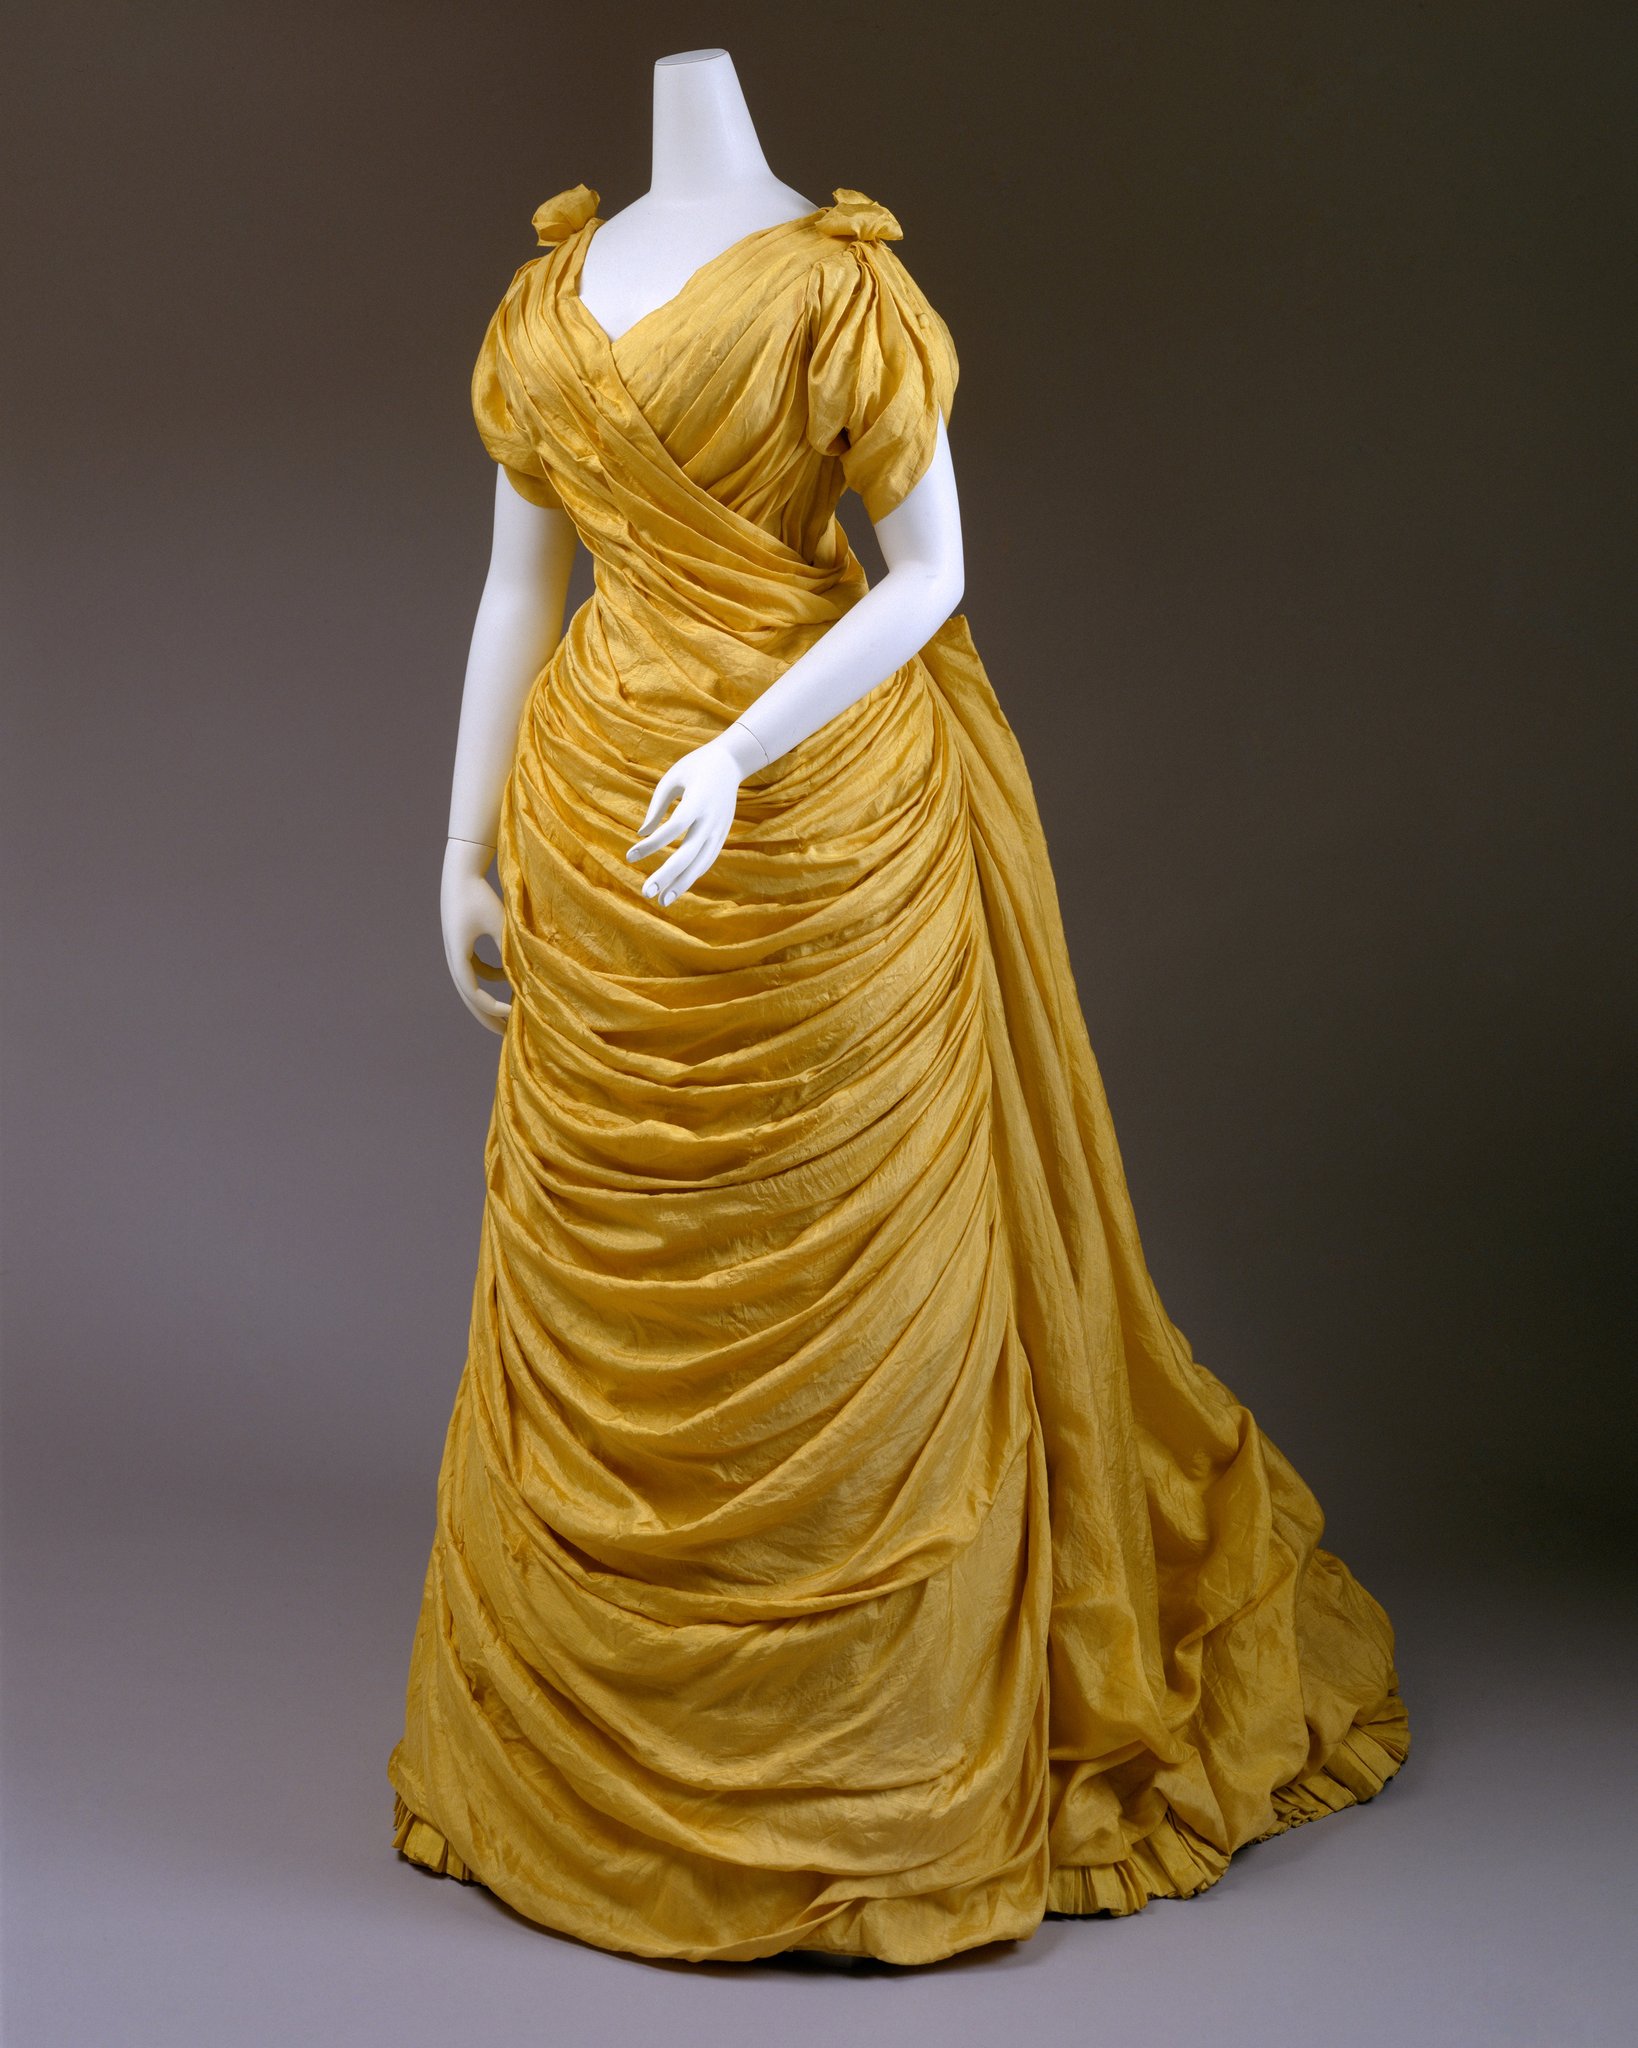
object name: evening dress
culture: british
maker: liberty & co.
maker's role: design house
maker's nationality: british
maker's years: 1875-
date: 1880-1889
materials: silk